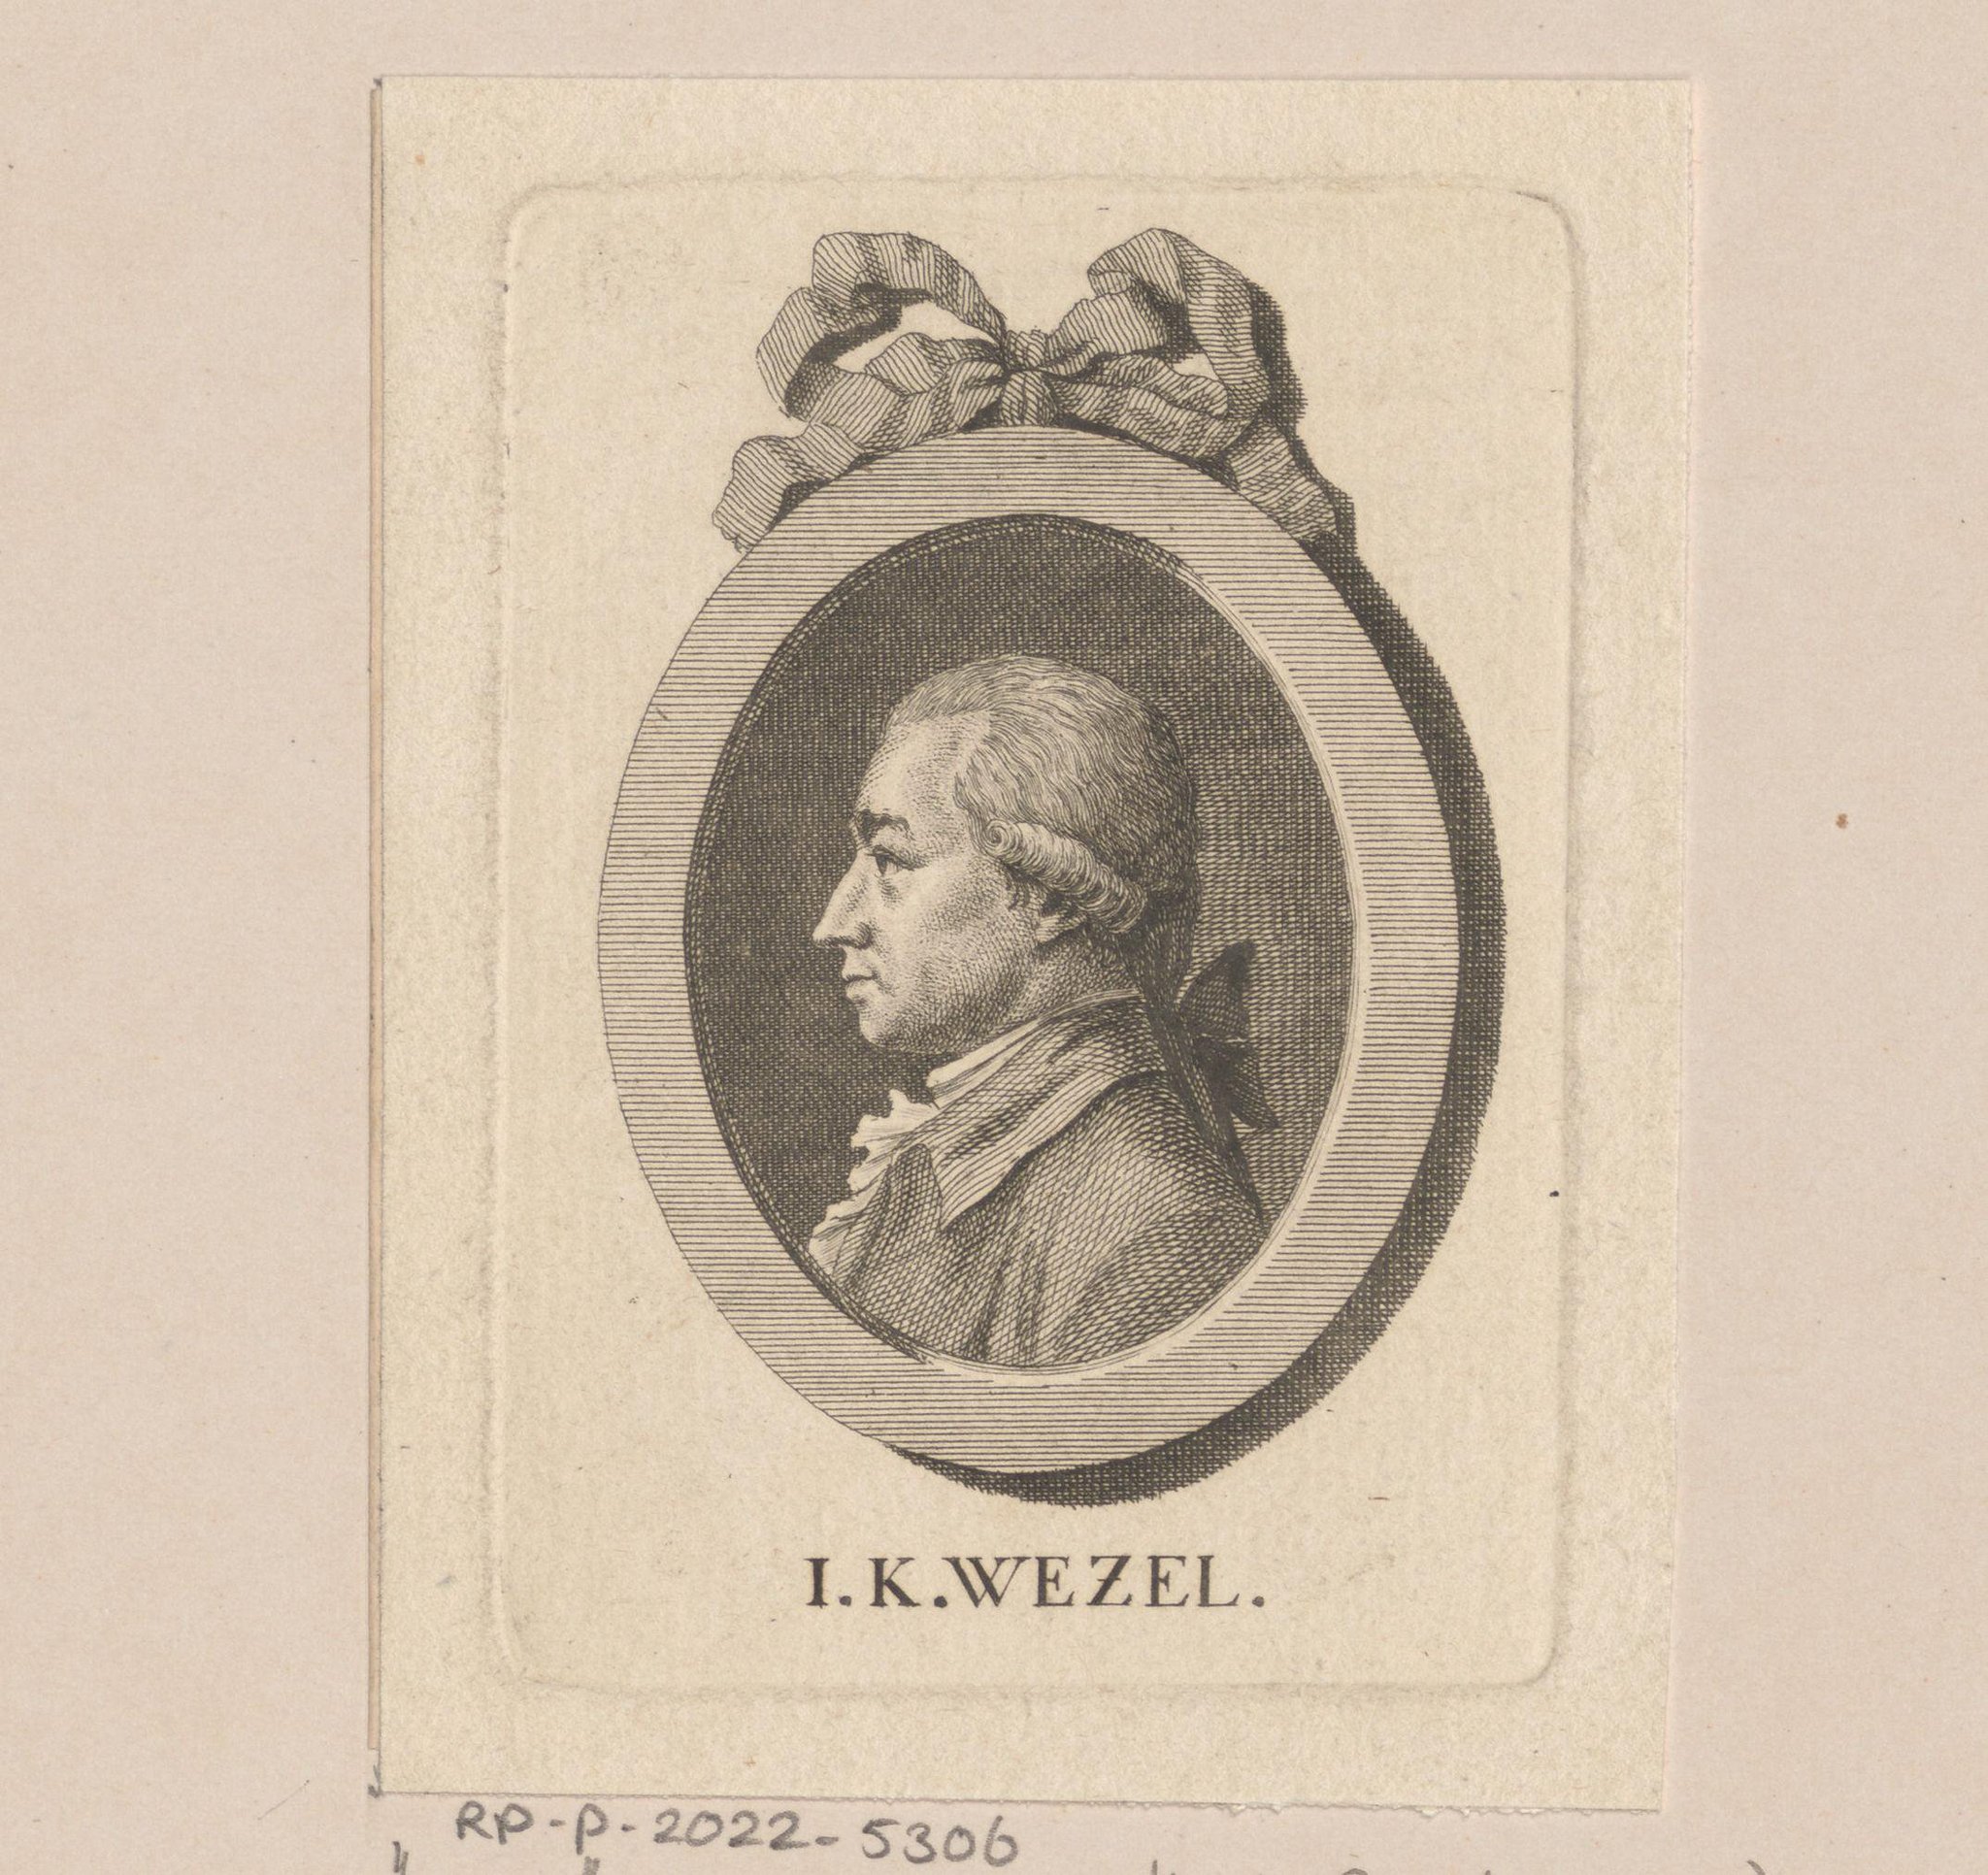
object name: print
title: Portret van Johann Karl Wezel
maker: Anonymous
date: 1777-1830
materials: paper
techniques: engraving, etching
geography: germany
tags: historical persons, portrait of a writer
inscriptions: number: ‘5717’